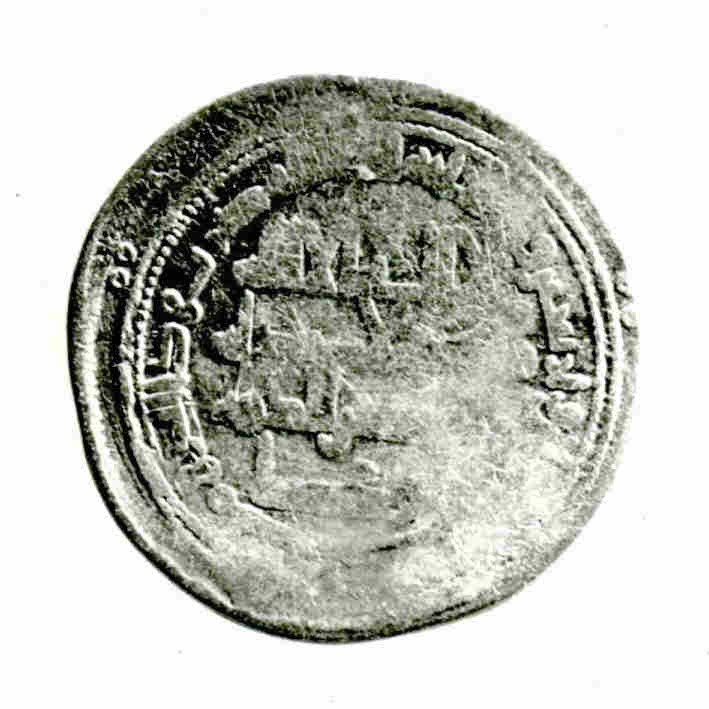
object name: coin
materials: silver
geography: iran